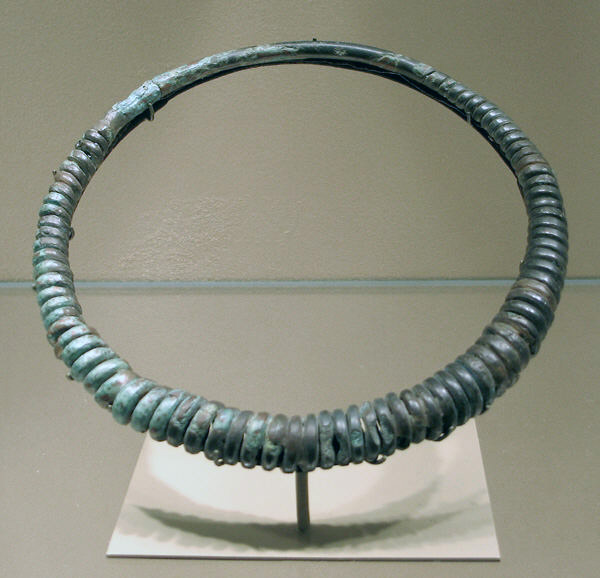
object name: torque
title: Torque of Twisted Wire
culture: thai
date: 300 BCE-200 CE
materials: bronze